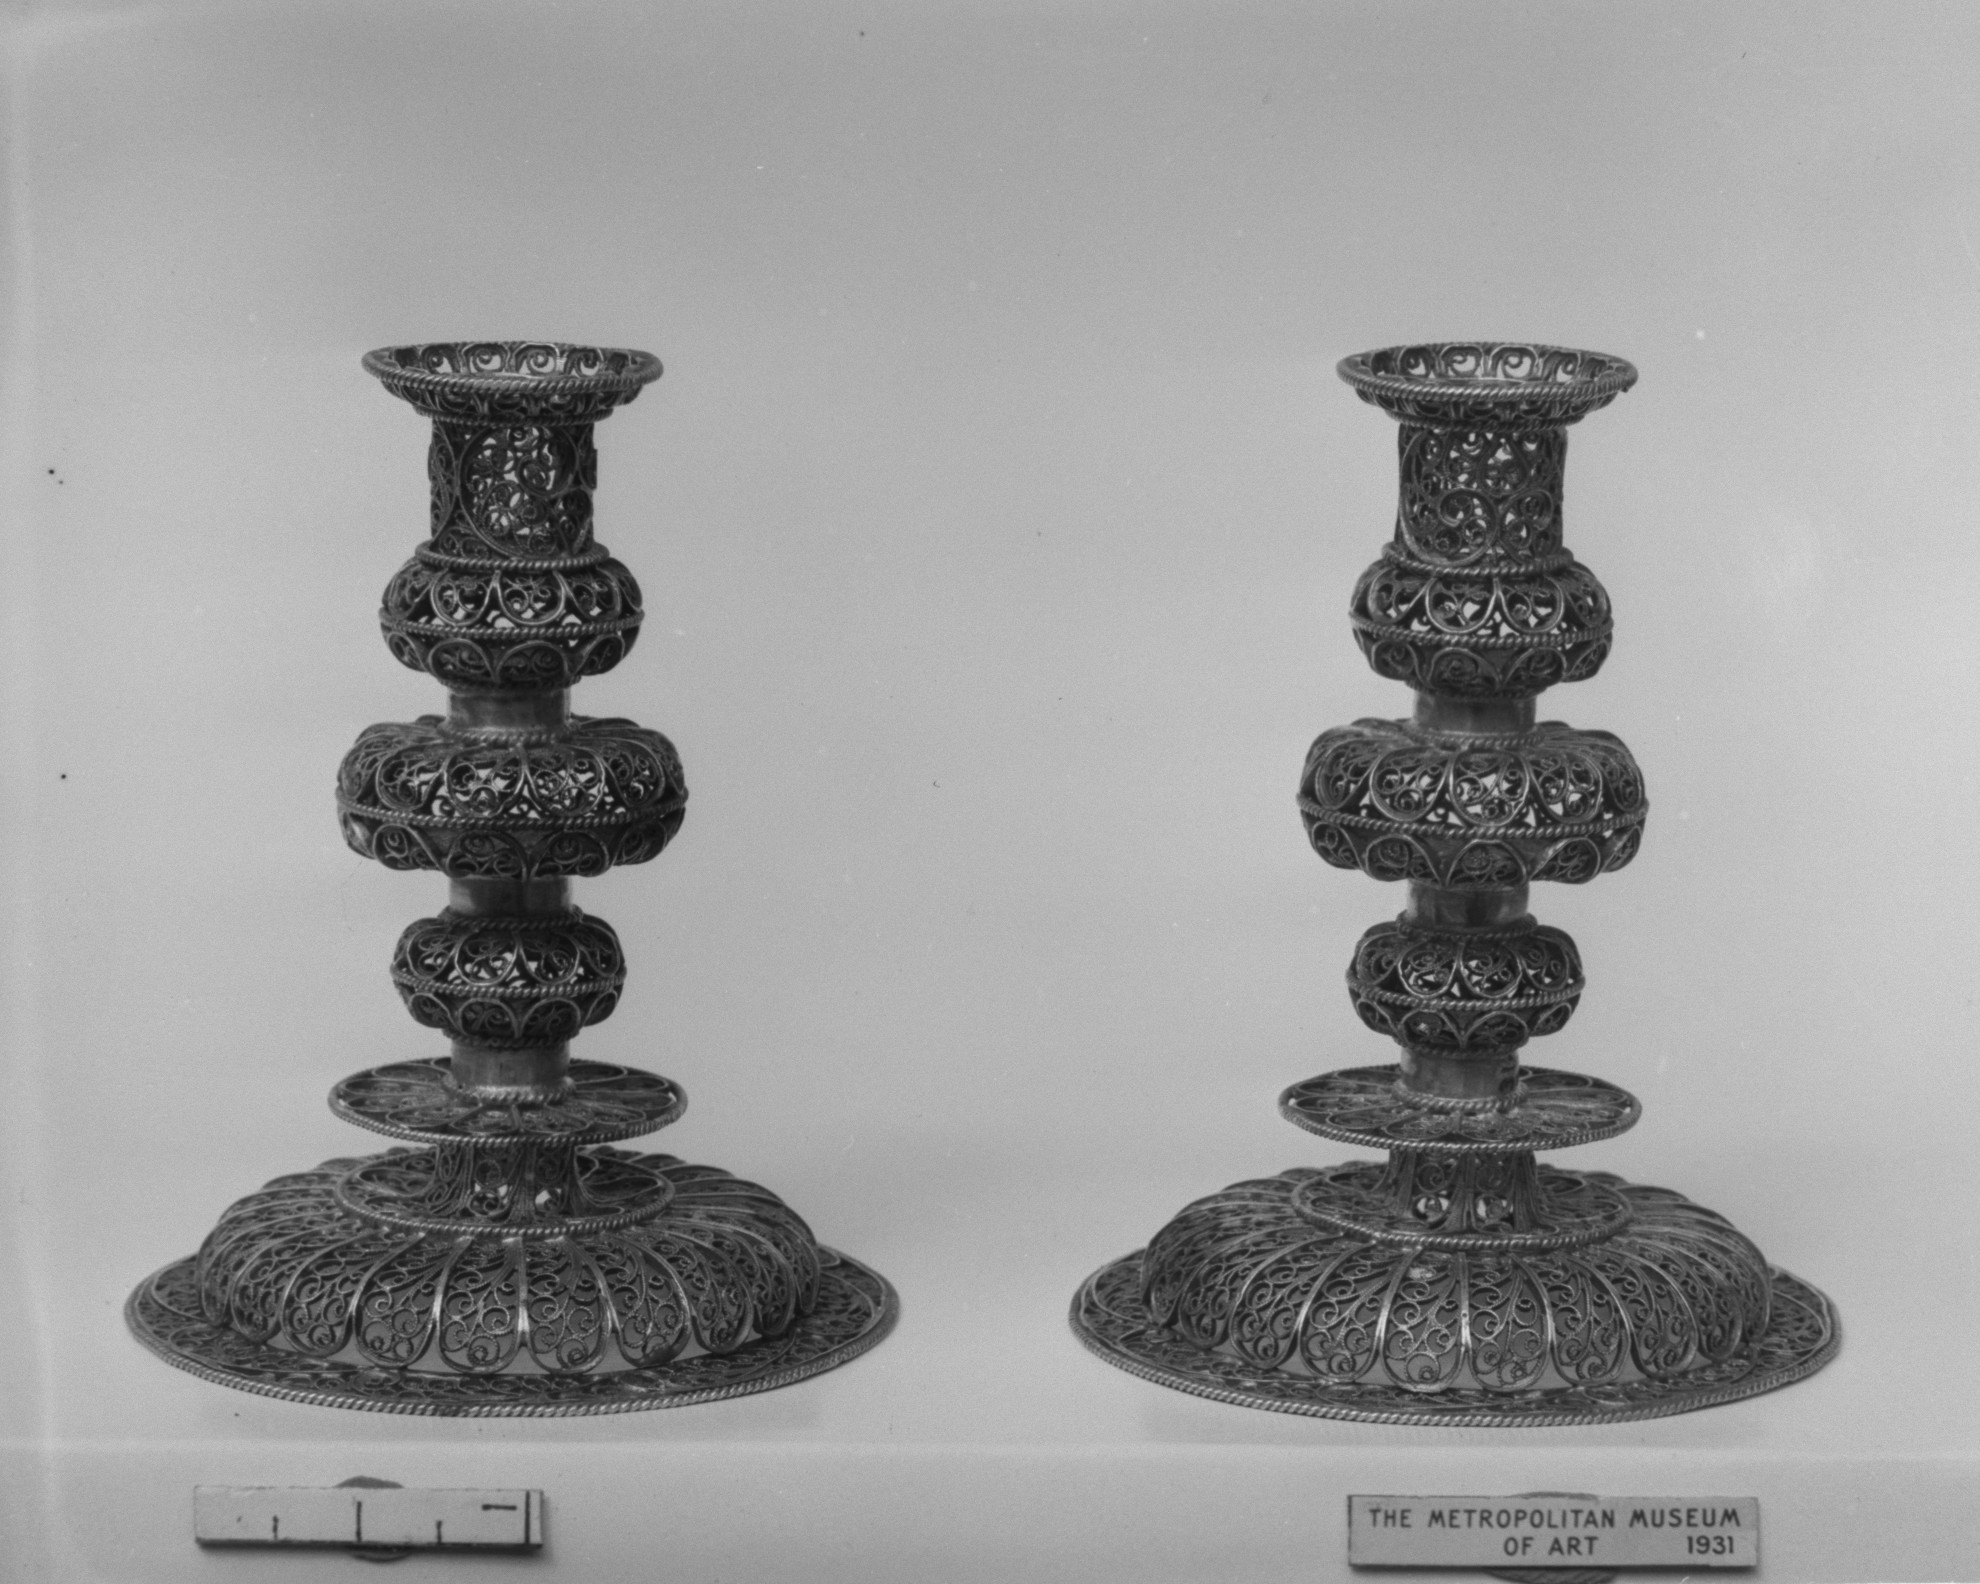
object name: candlestick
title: Miniature candlestick (one of a pair) (part of a set)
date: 1675-1700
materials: silver